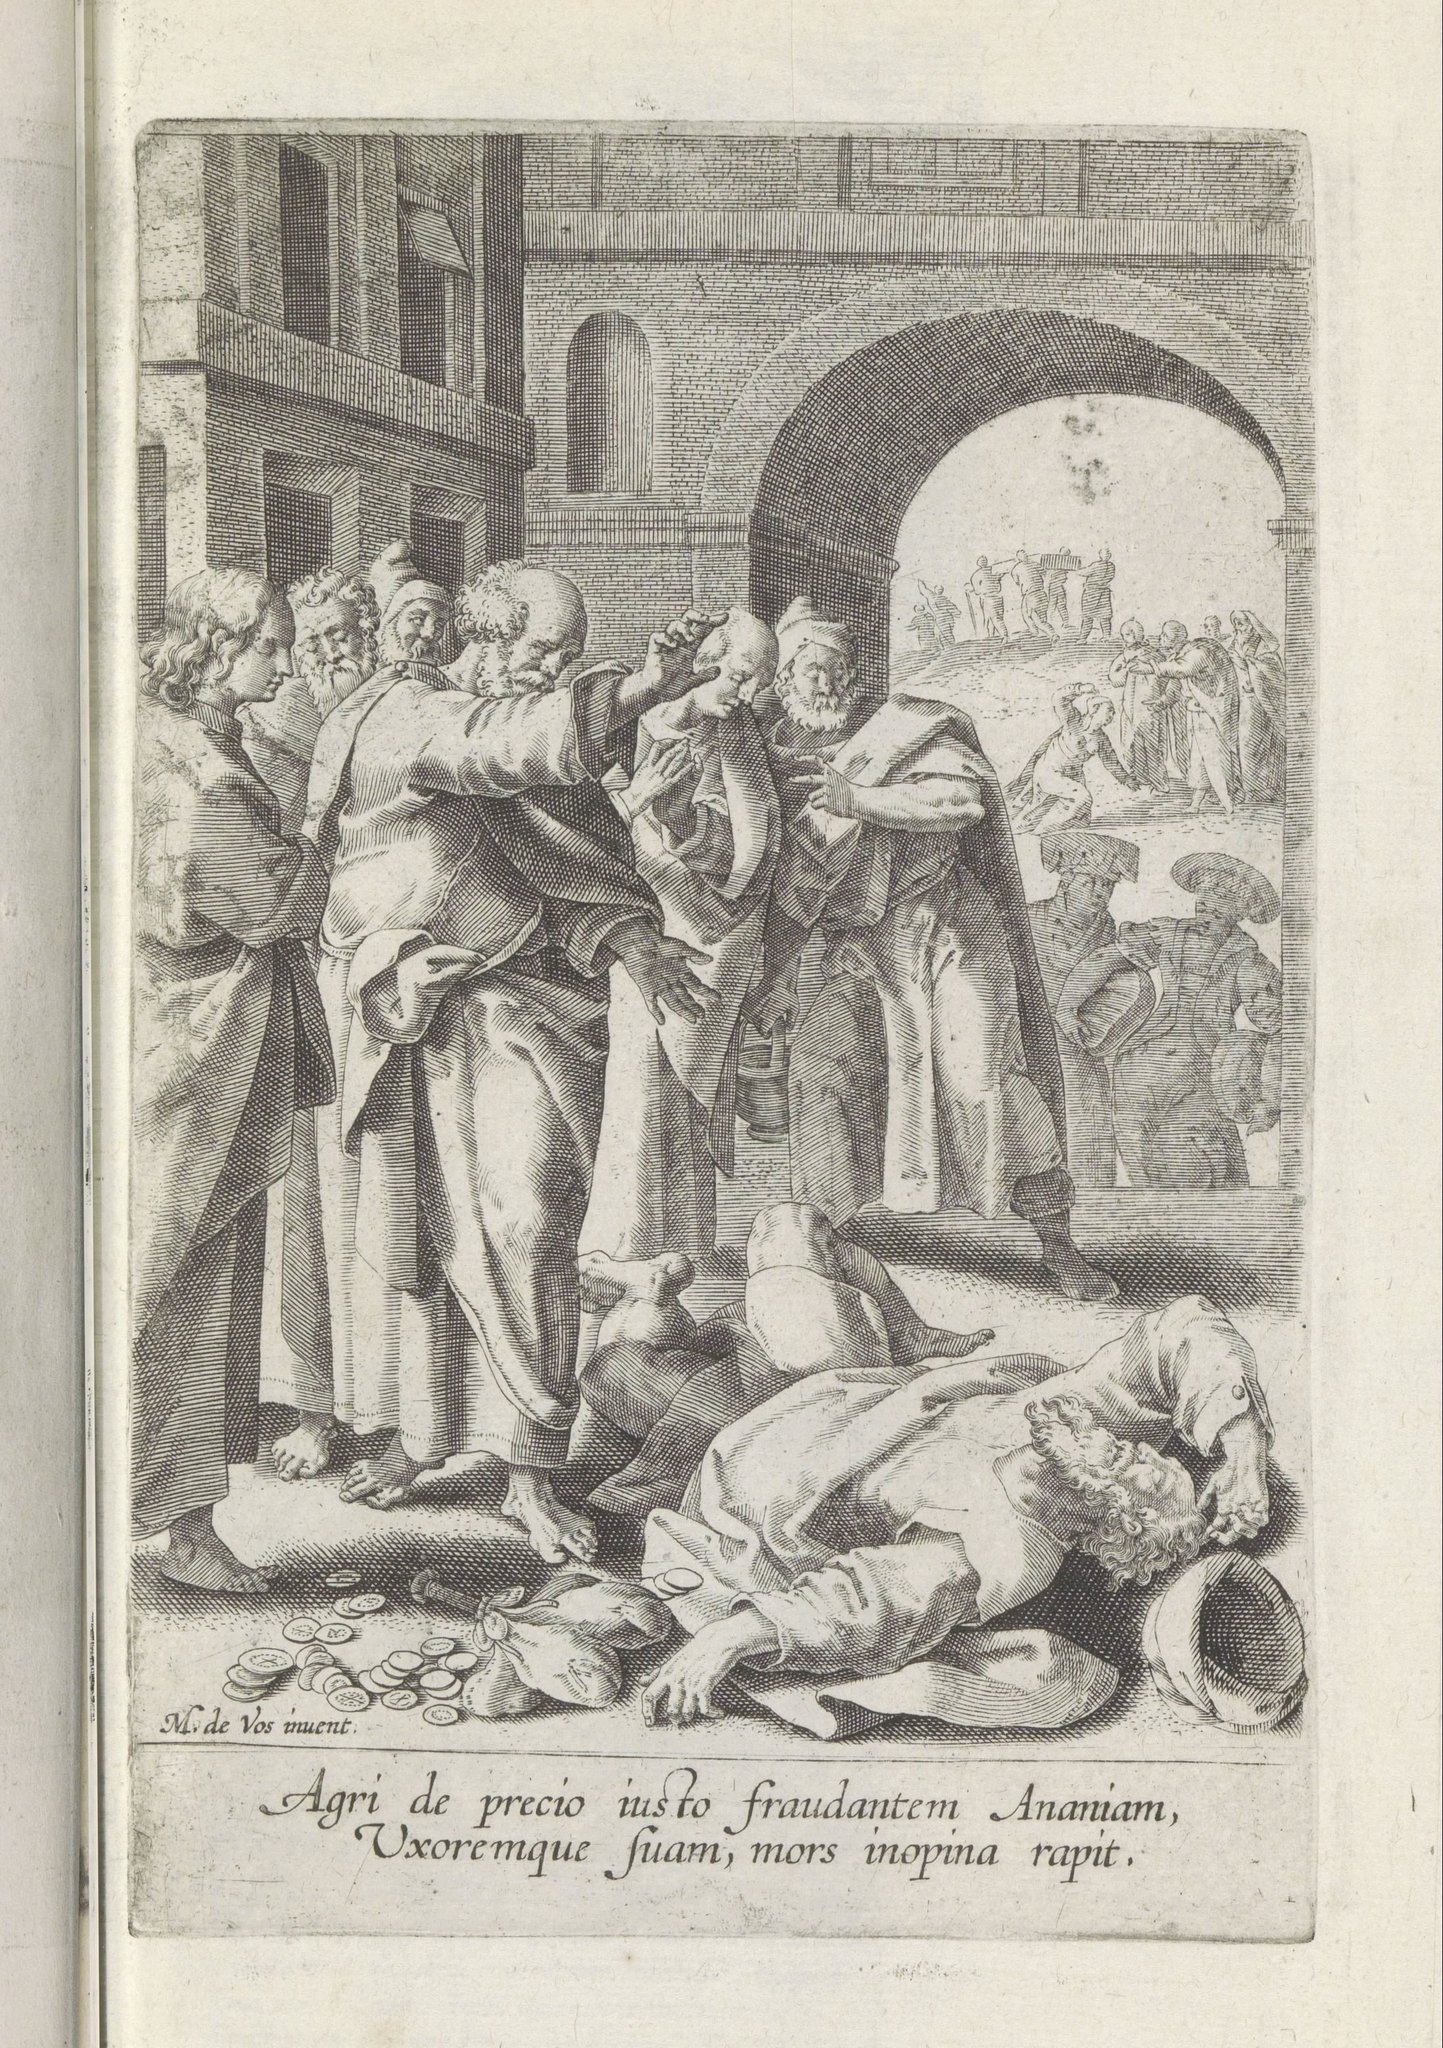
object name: album leaf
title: Dood van Ananias en Saffira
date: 1585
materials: paper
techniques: engraving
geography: antwerp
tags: ananias, rebuked by peter, falls down and dies between his gifts, peter questioning sapphira, who then dies too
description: Vooraan ligt het lichaam van Ananias op de grond naast zijn geldbuidel. Voor hem staat Petrus, die Ananias met woorden had gegeseld, omdat hij een deel van de opbrengst uit de verkoop van zijn bezit ten behoeve van de armen had achtergehouden, waarna Ananias stierf. Omstanders, onder wie enkele apostelen, kijken toe. Op de achtergrond ondergaat Saffira, Ananias' vrouw, hetzelfde lot. In de verte worden de lichamen weggedragen. Onder de voorstelling een tweeregelige tekst in het Latijn. Deze prent maakt deel uit van een album.